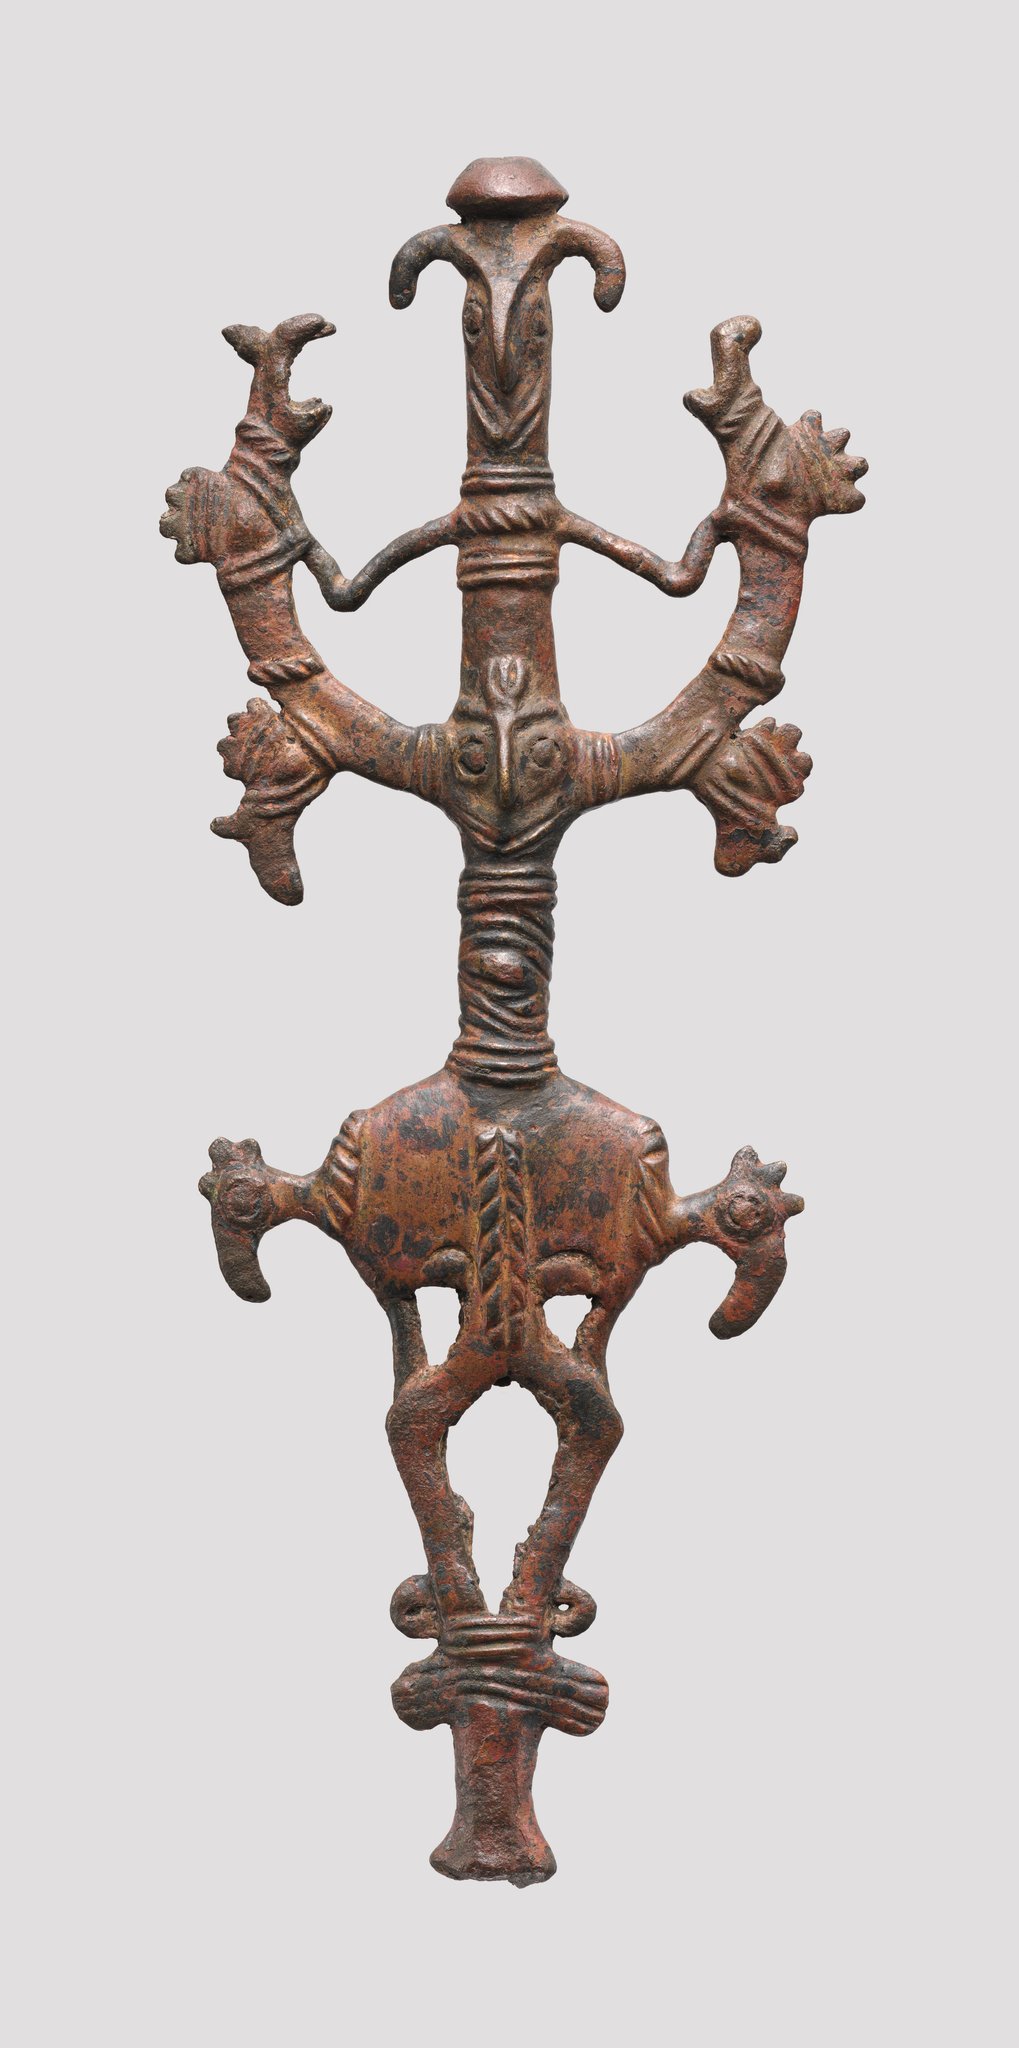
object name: standard top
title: Top for standard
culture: iranian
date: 800-601 BCE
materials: bronze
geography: iran, probably from luristan